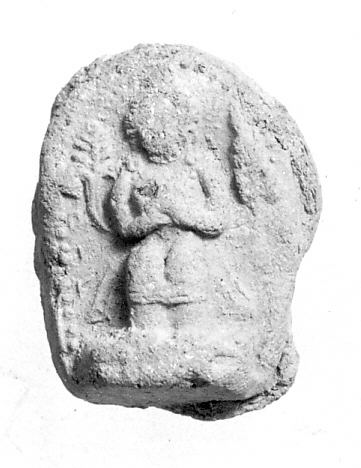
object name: votive plaque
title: Votive Plaque with Maitreya(?)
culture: central asian or tibetan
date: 1401-1700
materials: clay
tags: buddhism,maitreya